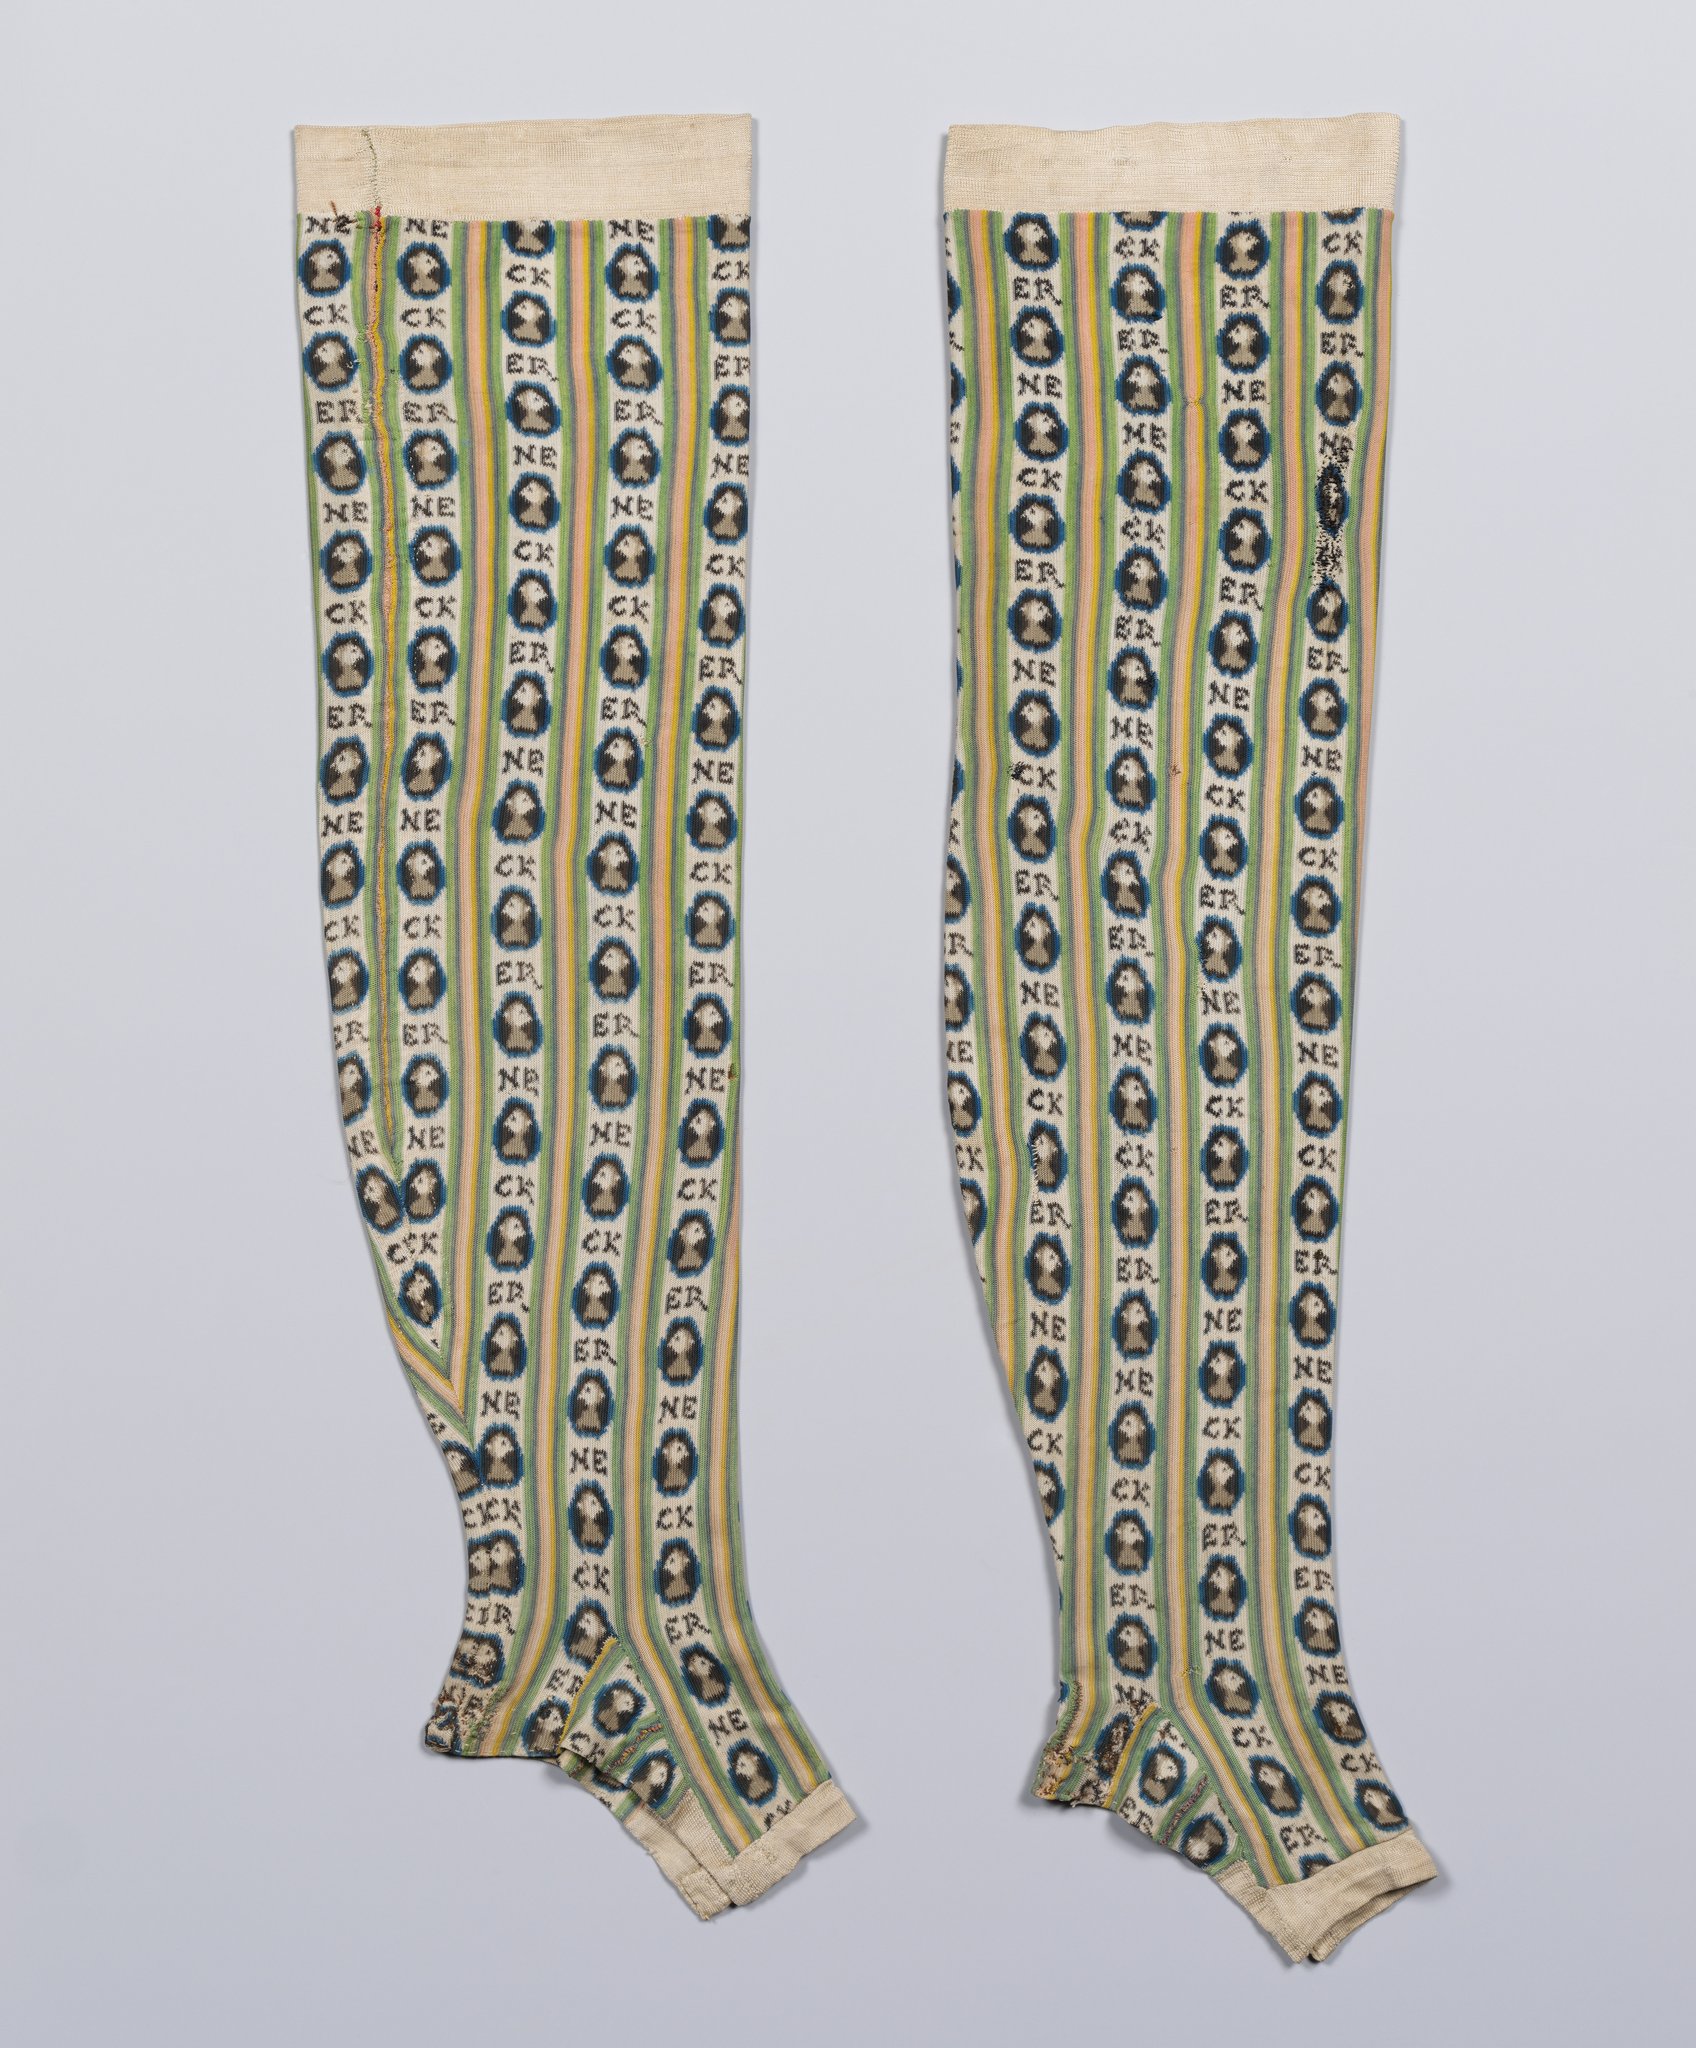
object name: stocking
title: Stockings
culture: french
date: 1788-1793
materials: silk